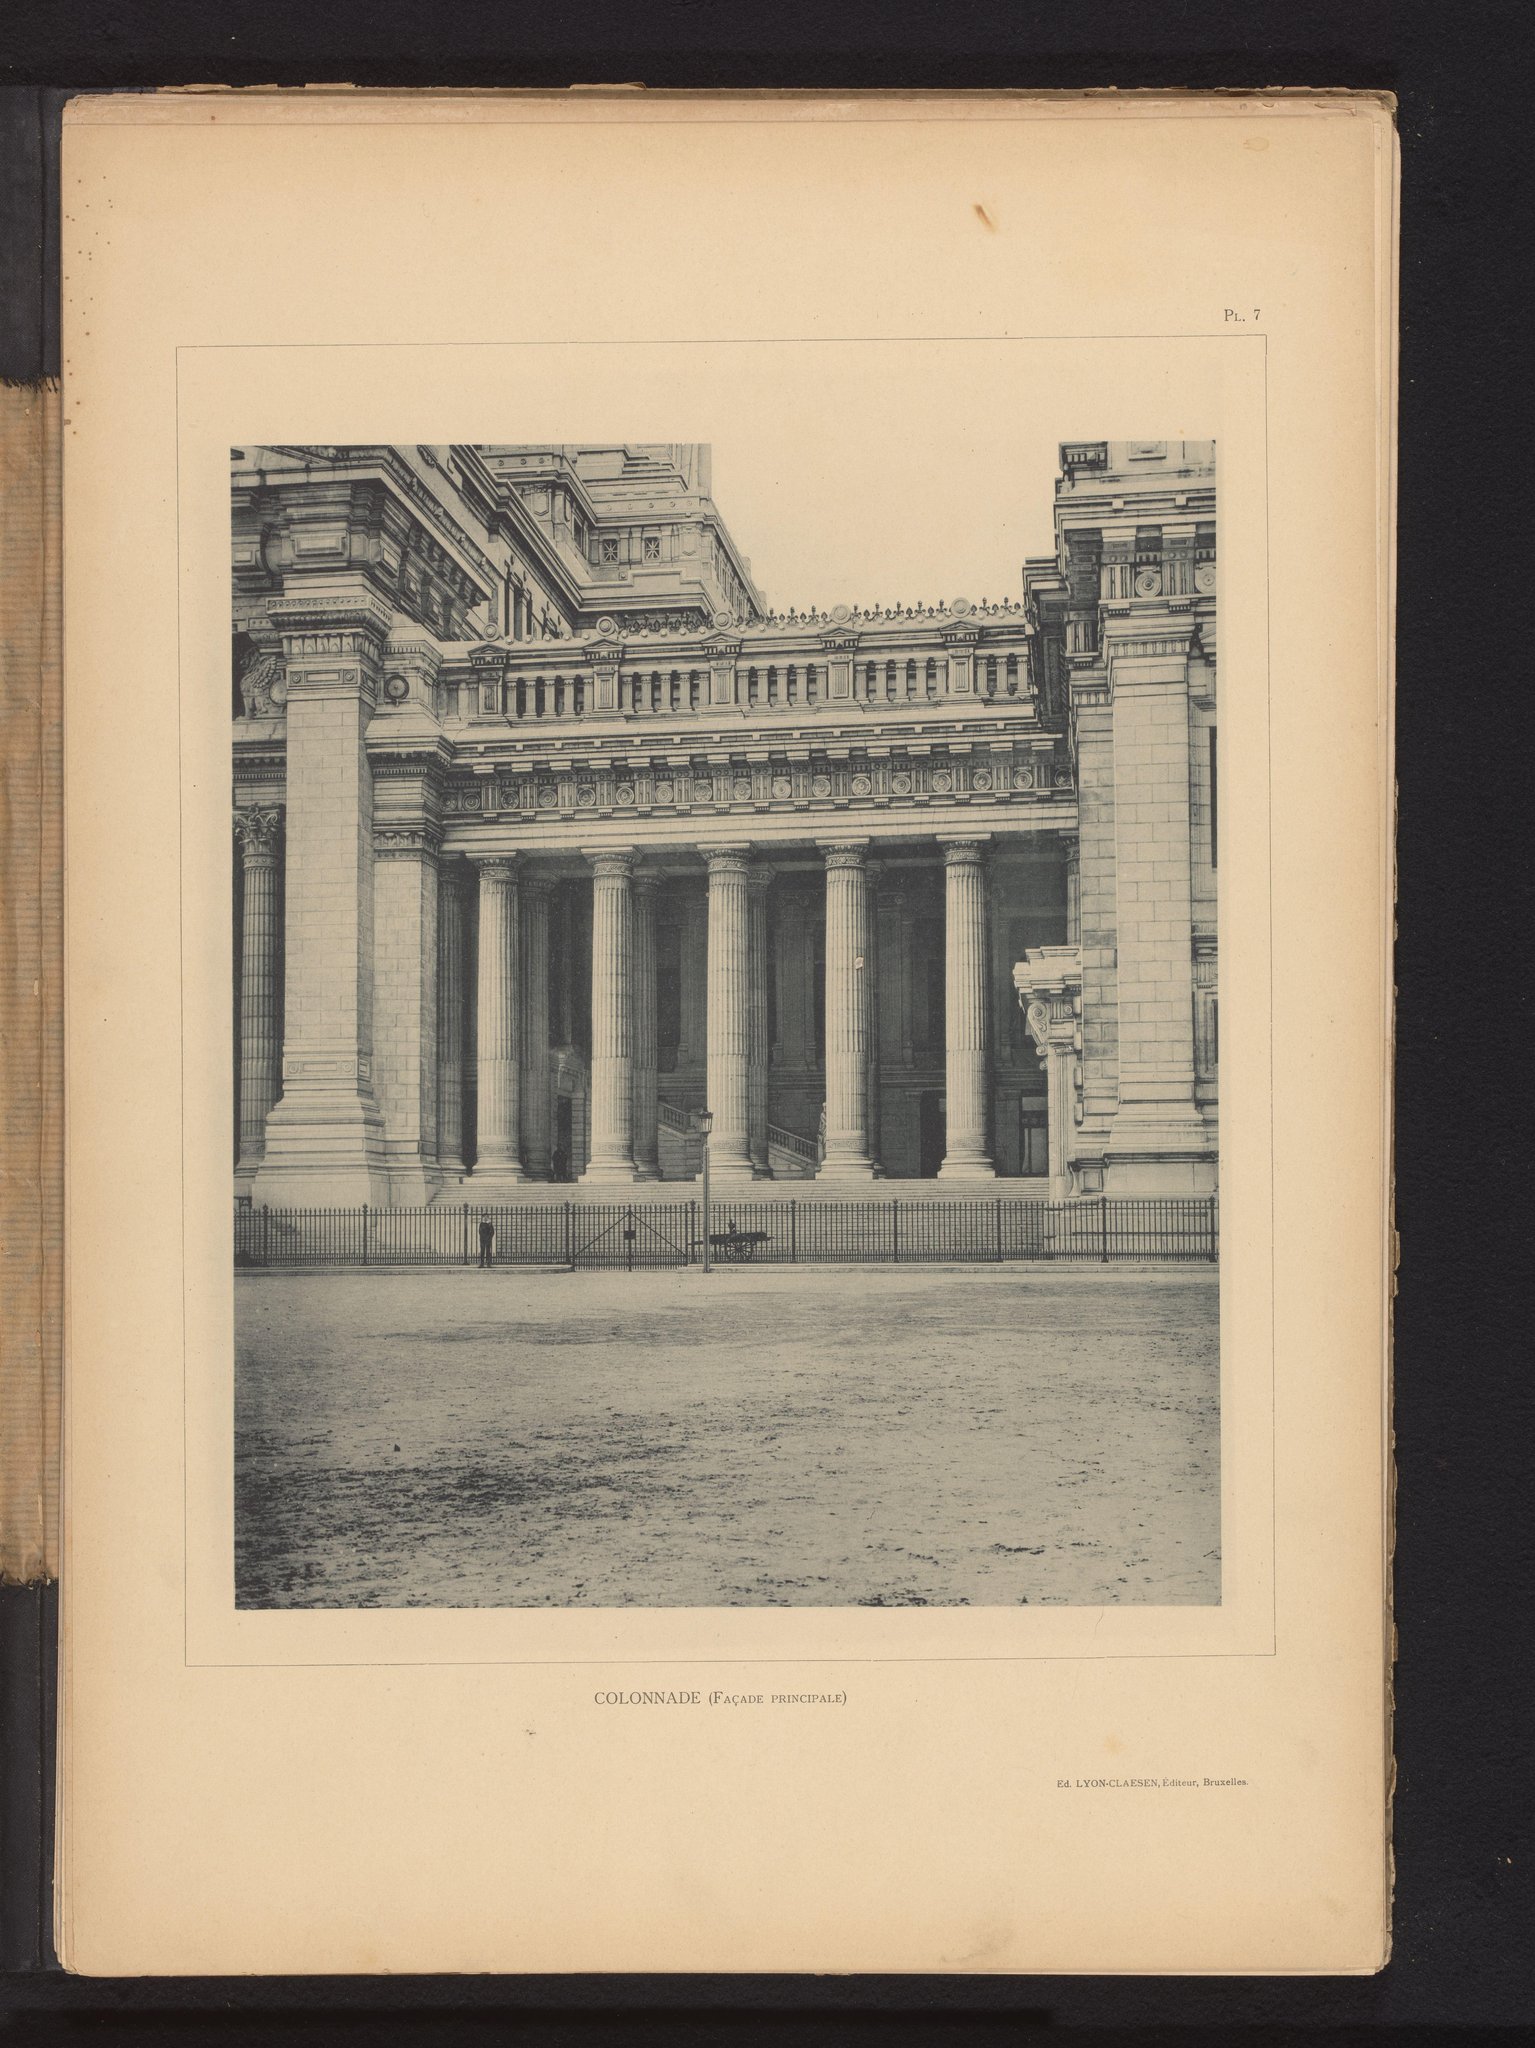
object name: photomechanical print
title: Colonnade (Façade Principale)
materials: paper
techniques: photograph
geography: brussels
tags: court building, colonnade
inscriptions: number: ‘PL. 7’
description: Deze prent maakt deel uit van een omslag met 30 prenten op 28 bladen en een titelblad.